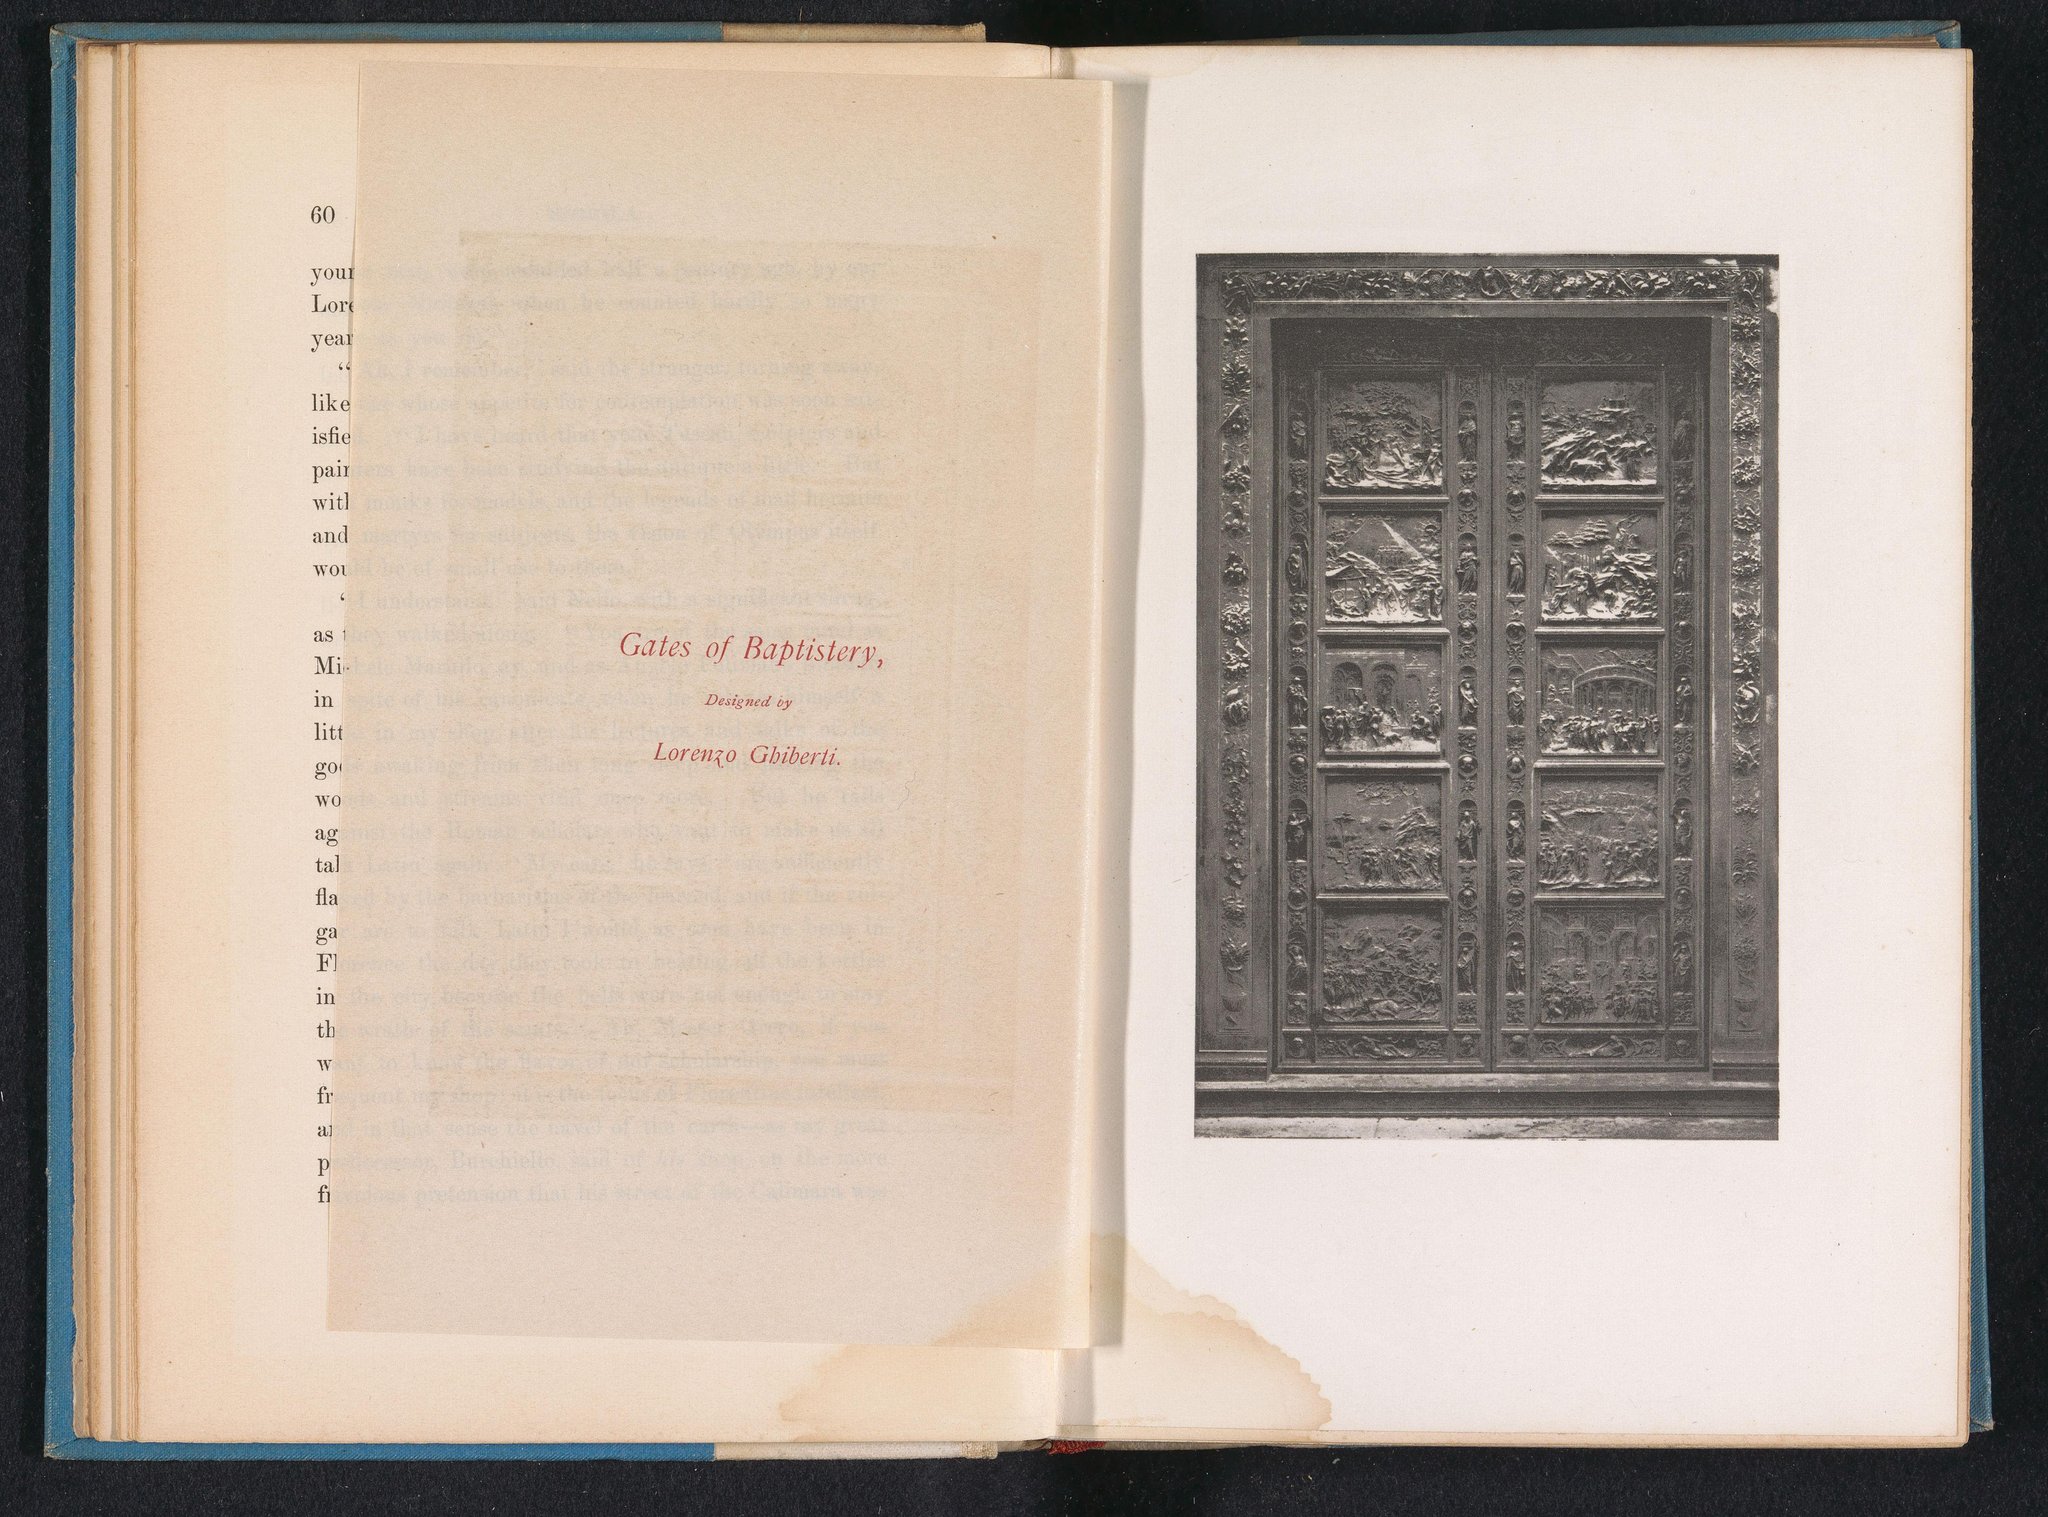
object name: photomechanical print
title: Bronzen deuren van het Baptisterium te Florence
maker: Anonymous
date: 1880-1890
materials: paper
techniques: photoaquatint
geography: boston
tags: closed door, sculpture (+ relief ~ sculpture)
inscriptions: title: ‘Gates of Baptistery, Designed by Lorenzo Ghiberti.’